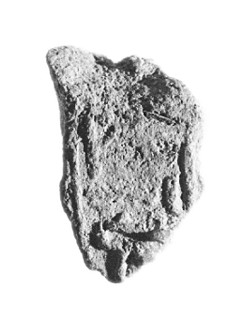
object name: sealing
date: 1981-1640 BCE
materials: mud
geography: egypt